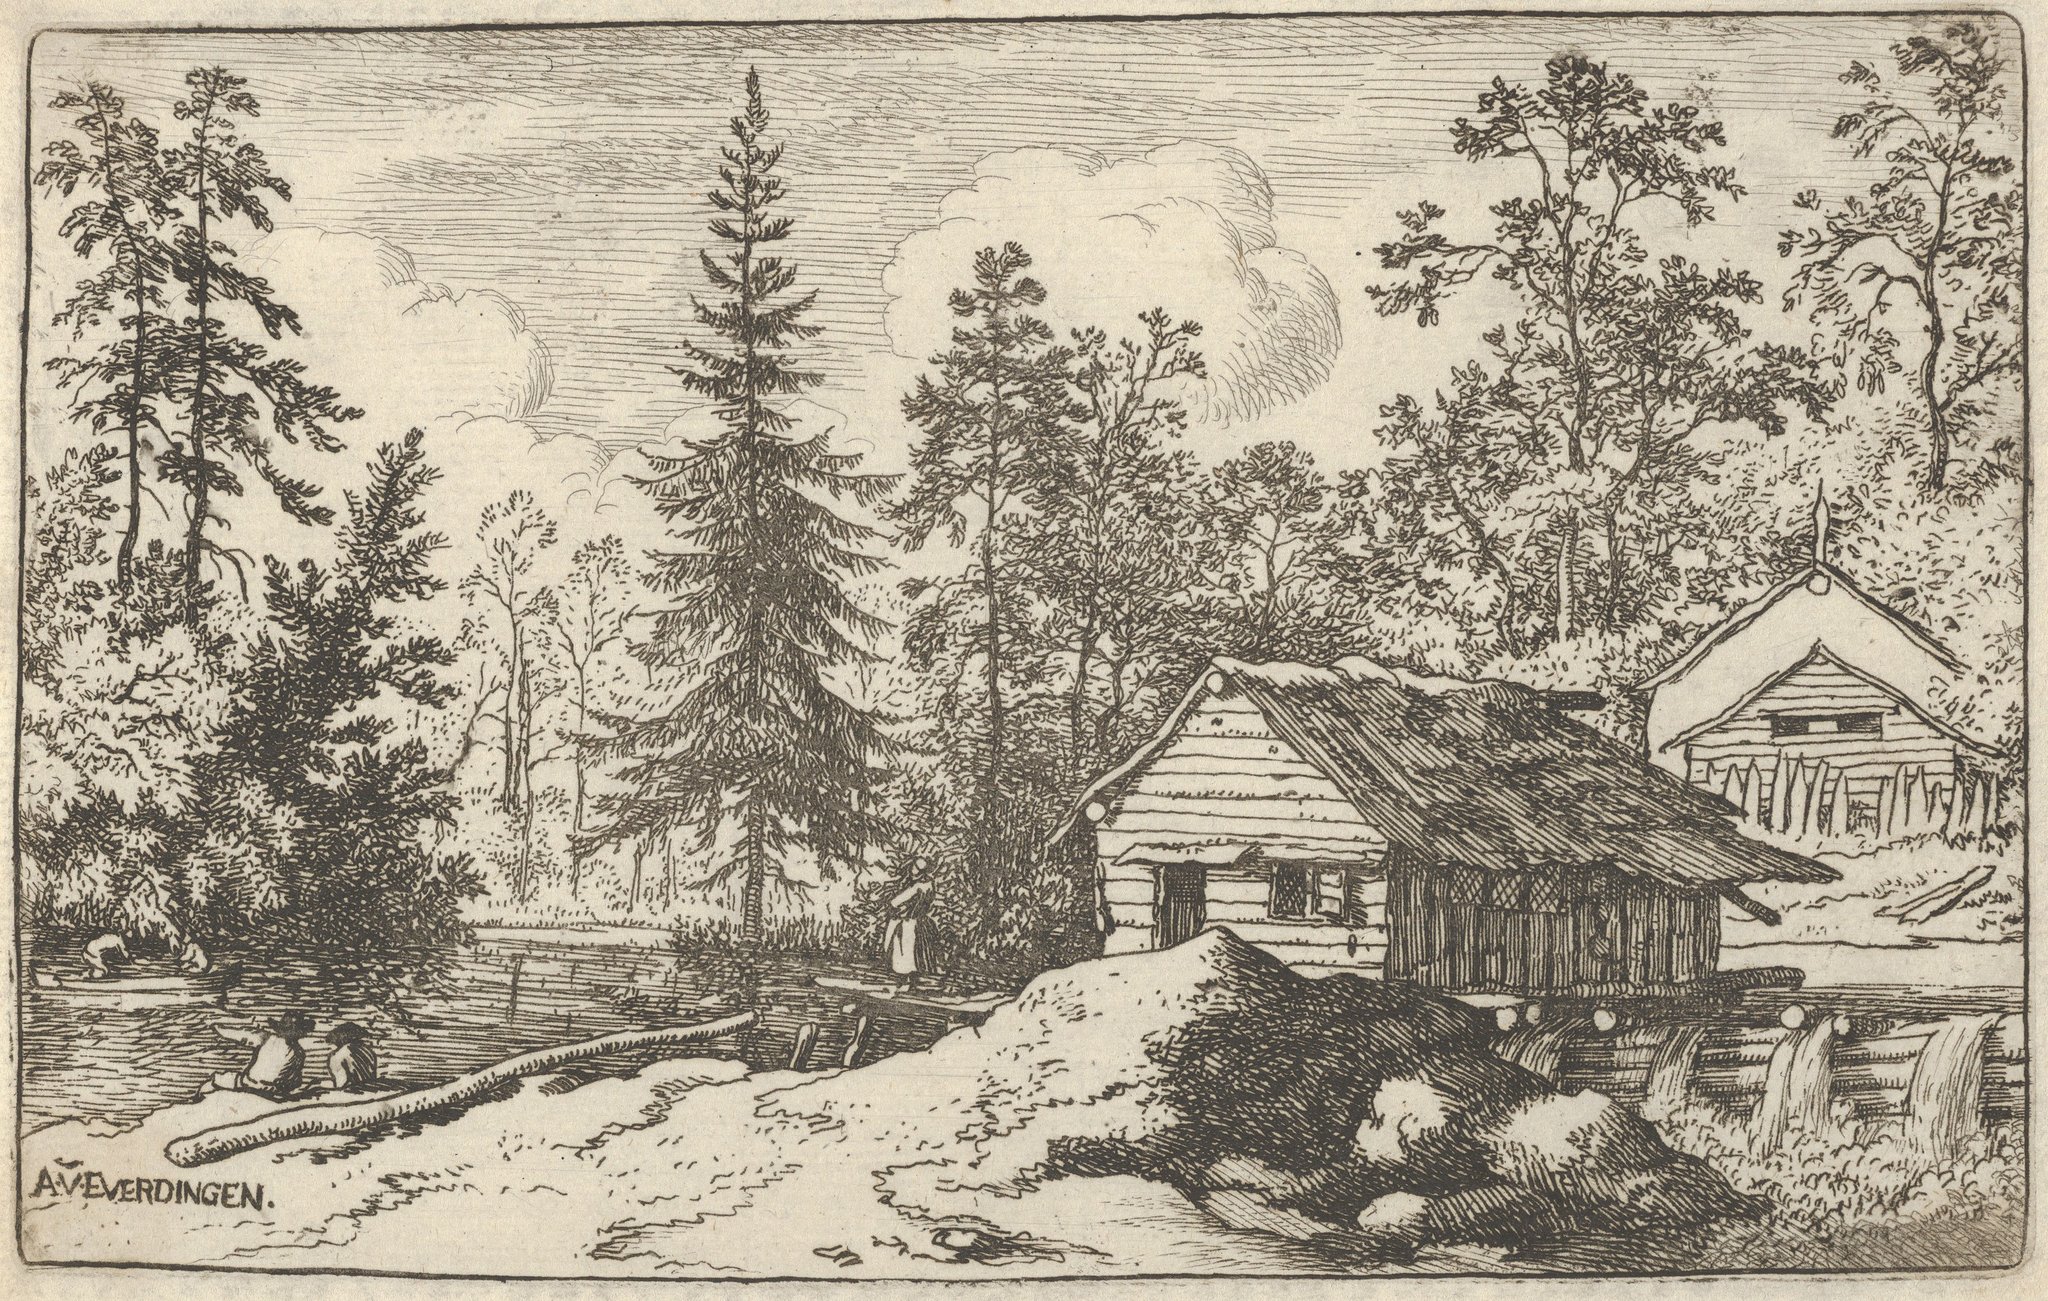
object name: print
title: The Woman Looking Towards the Boat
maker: allart van everdingen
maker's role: artist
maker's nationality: dutch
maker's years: 1621-1675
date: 1621-1675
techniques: engraving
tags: houses,women,trees,boats